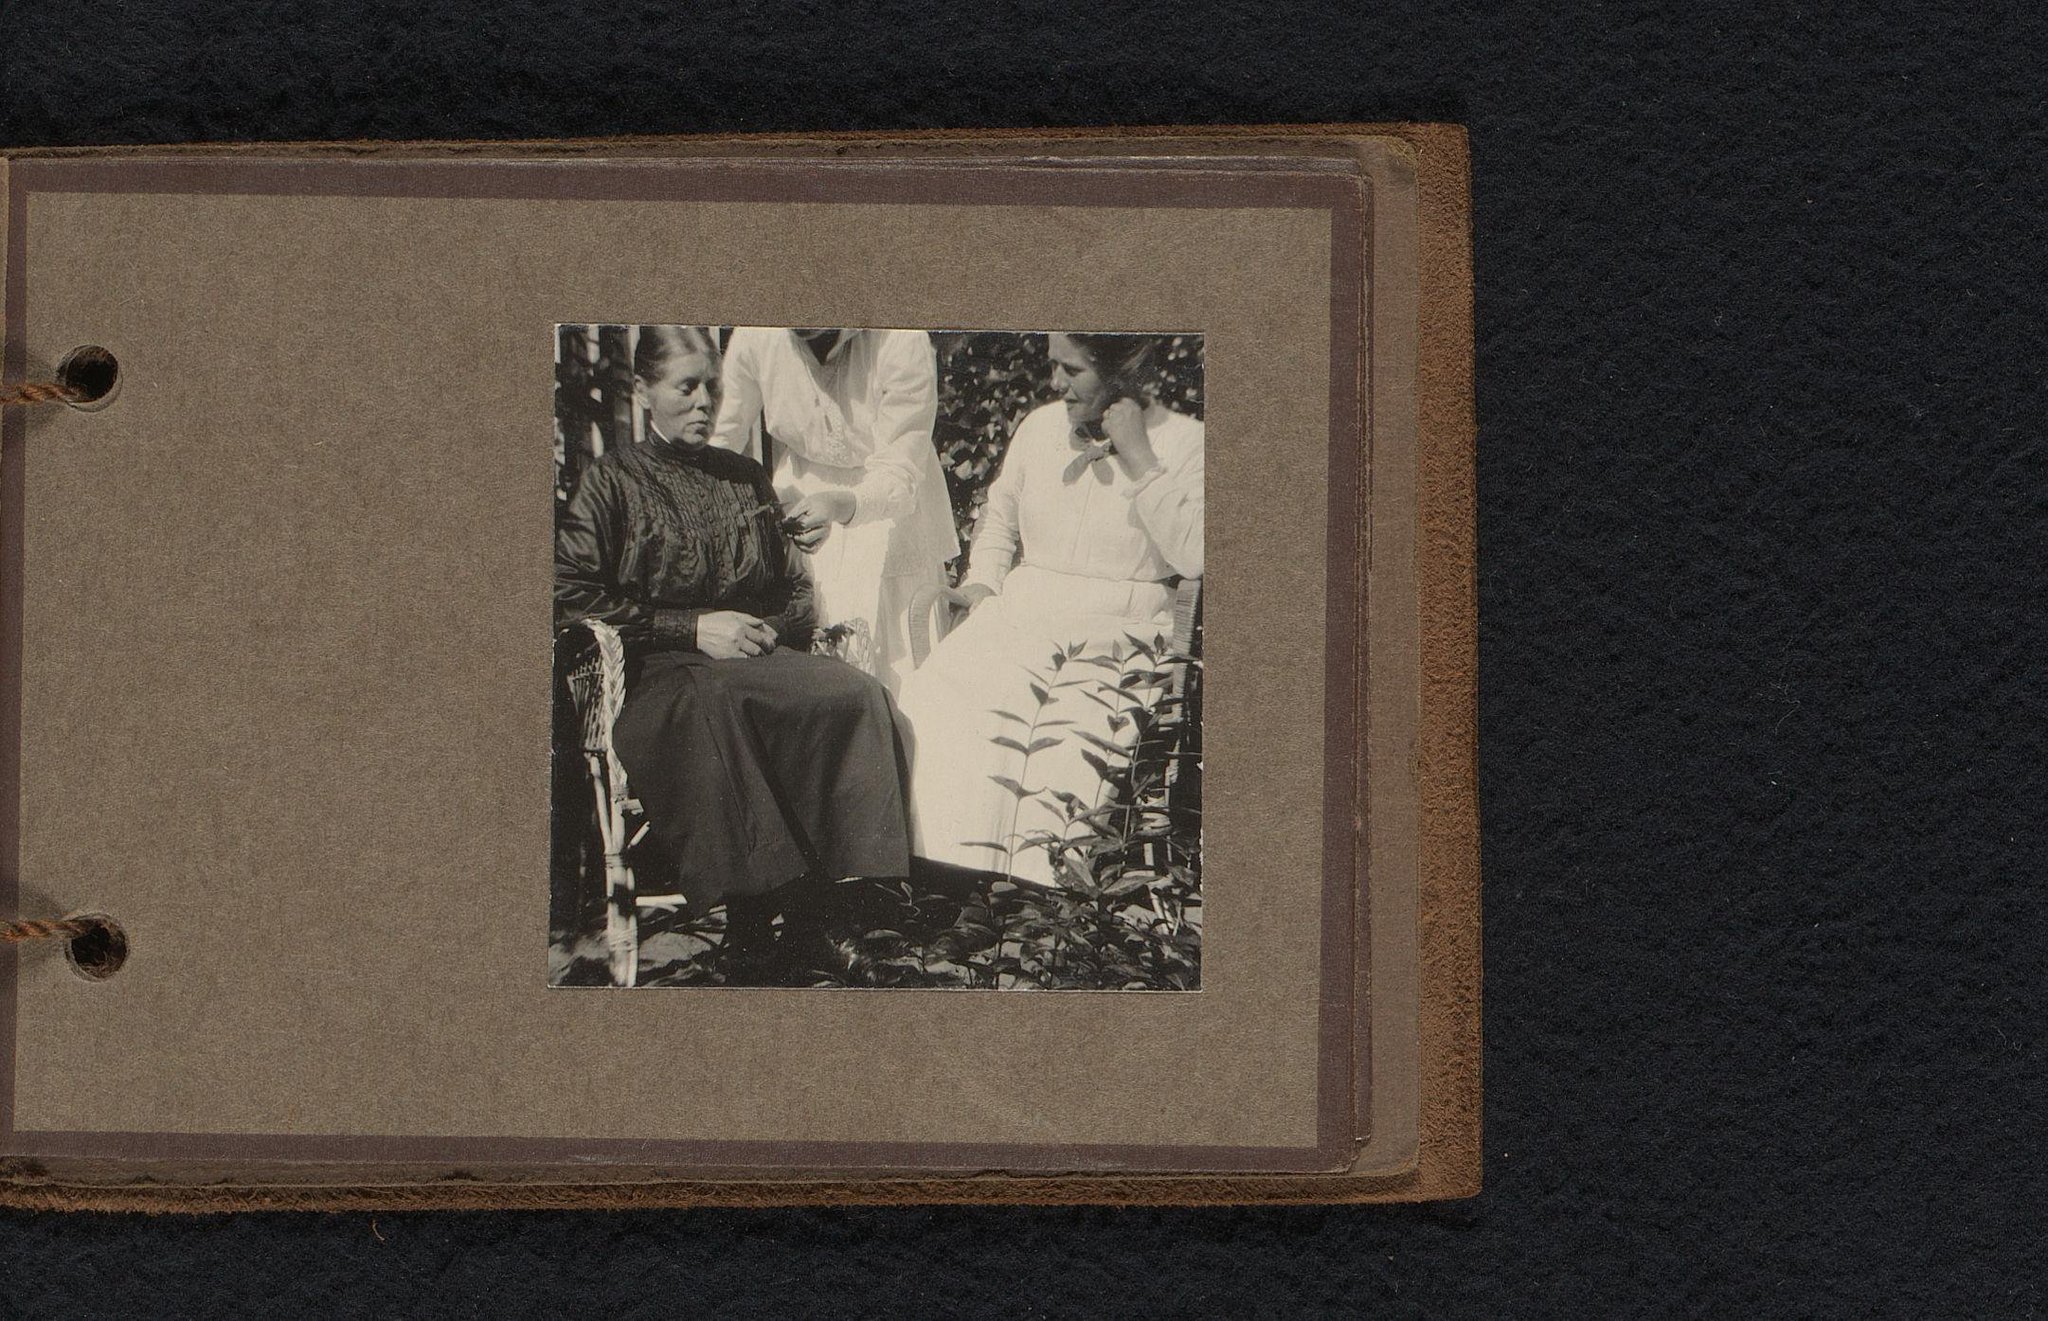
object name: photograph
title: Drie vrouwen in een tuin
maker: Anonymous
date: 1900-1930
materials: paper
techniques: gelatin silver print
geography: netherlands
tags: historical persons not known by name - bb - woman, garden